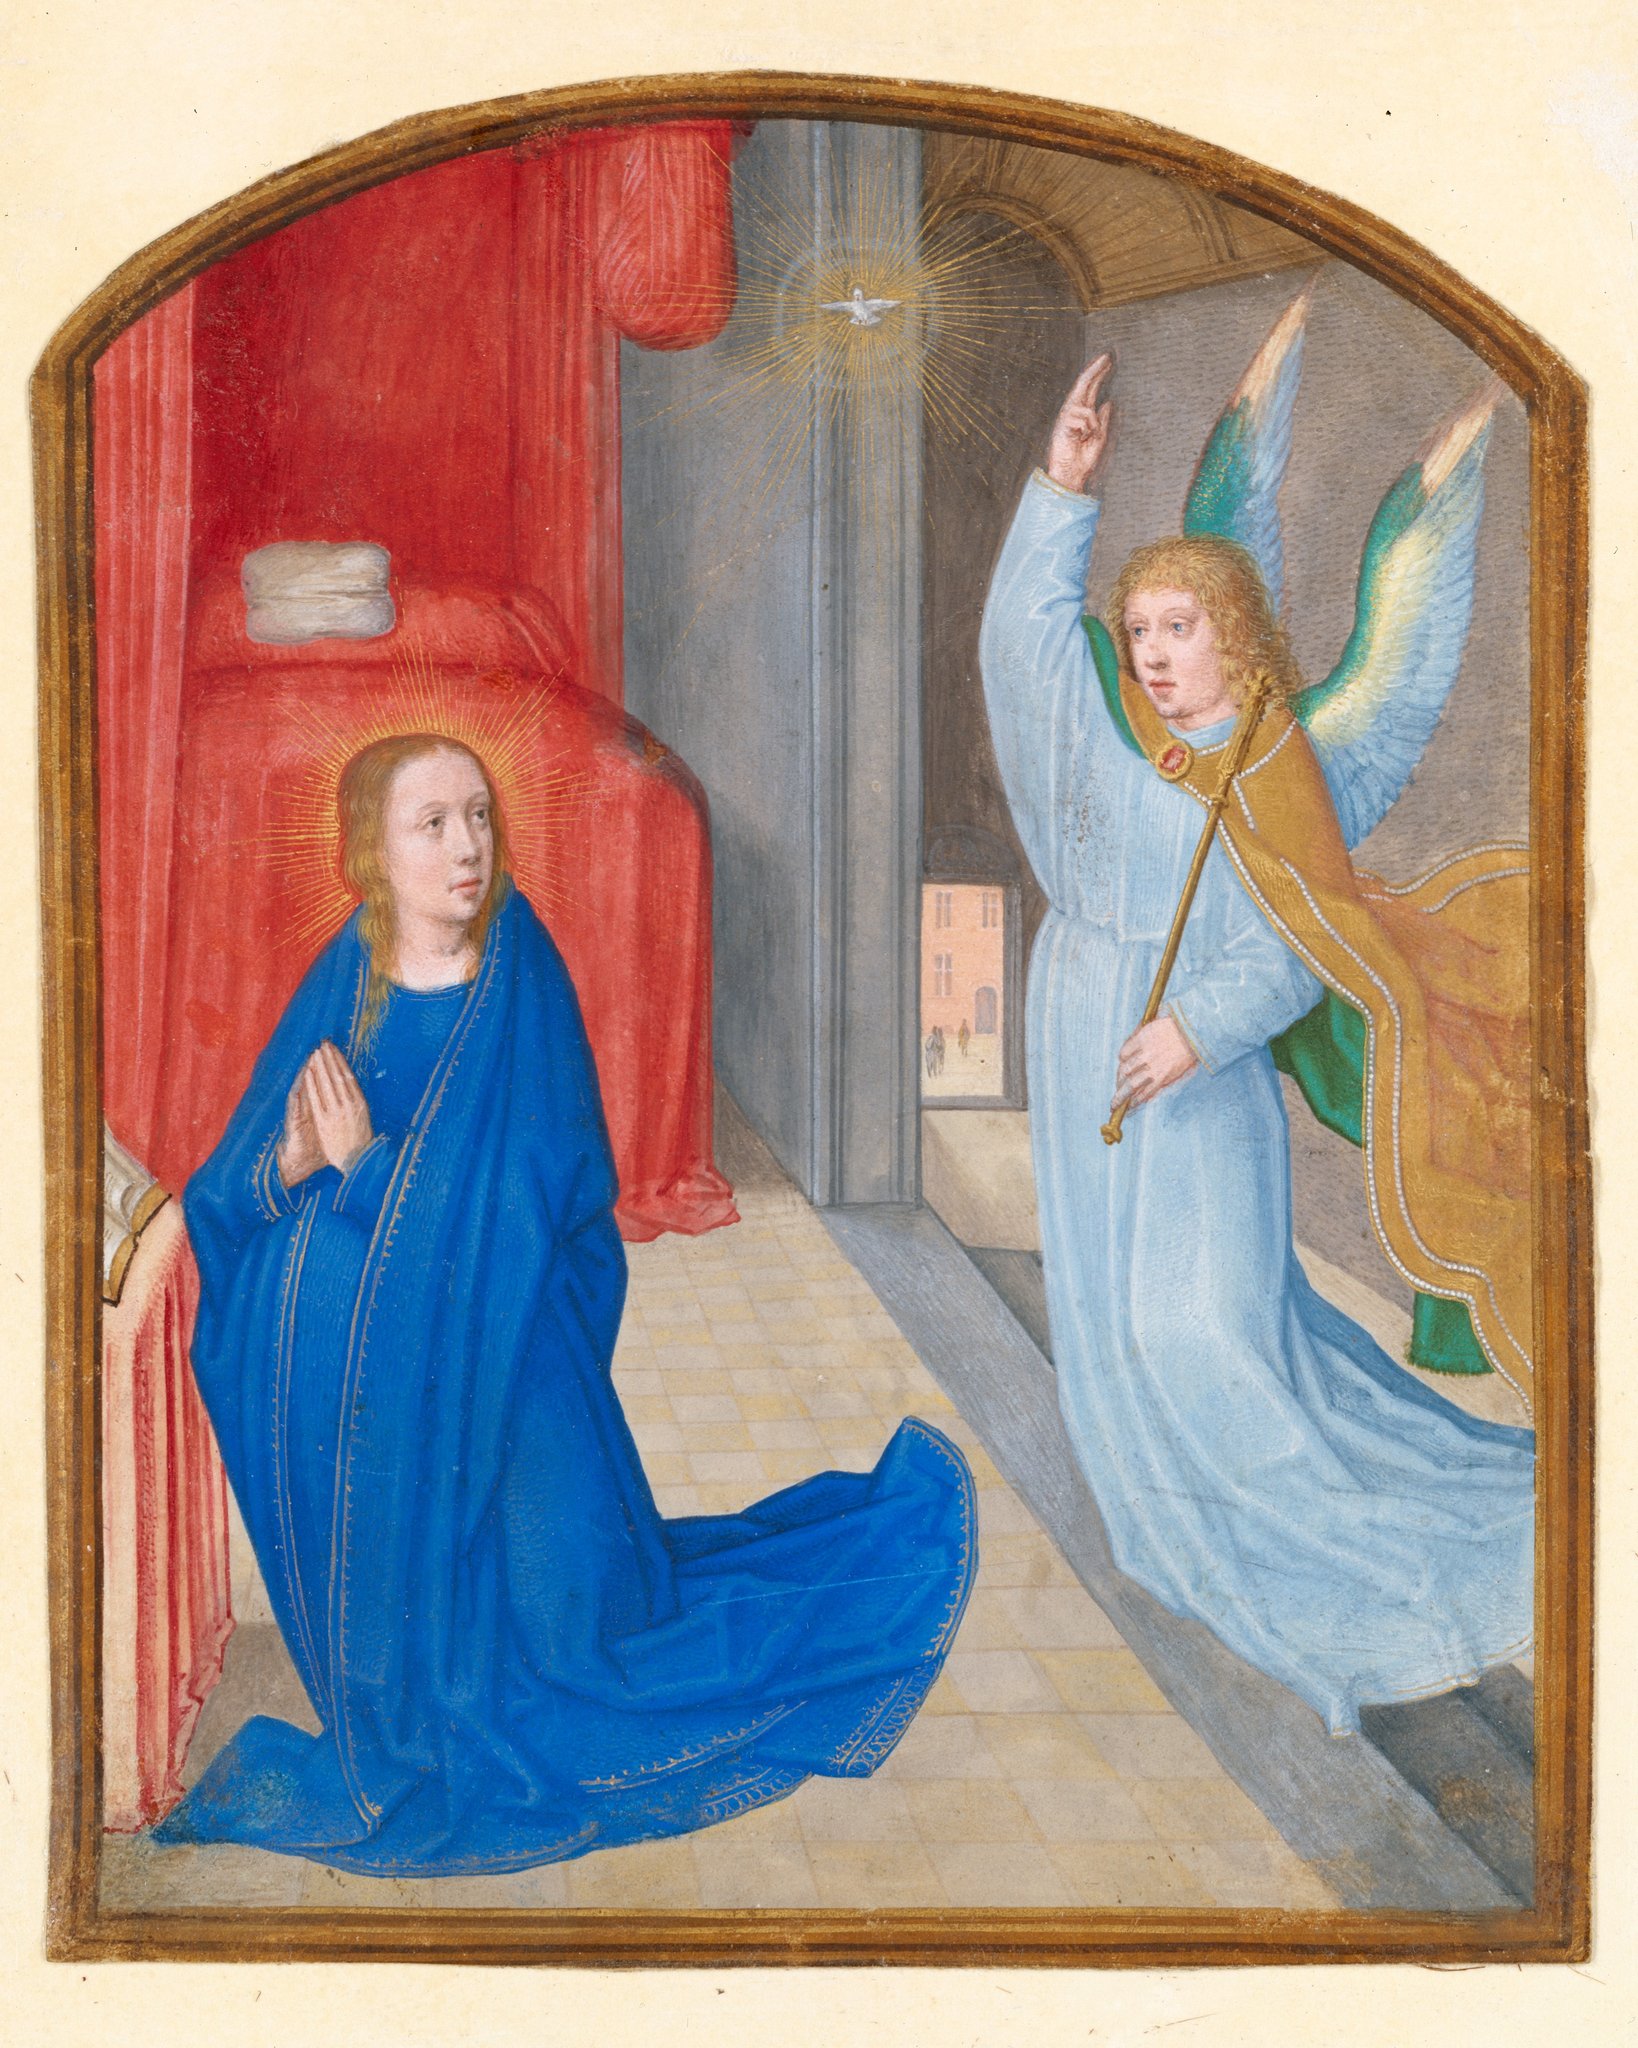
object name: miniature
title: The Annunciation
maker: gerard david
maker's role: artist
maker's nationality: netherlandish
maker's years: 1455-1523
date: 1510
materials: parchment, paint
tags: angels,virgin mary,annunciation,beds